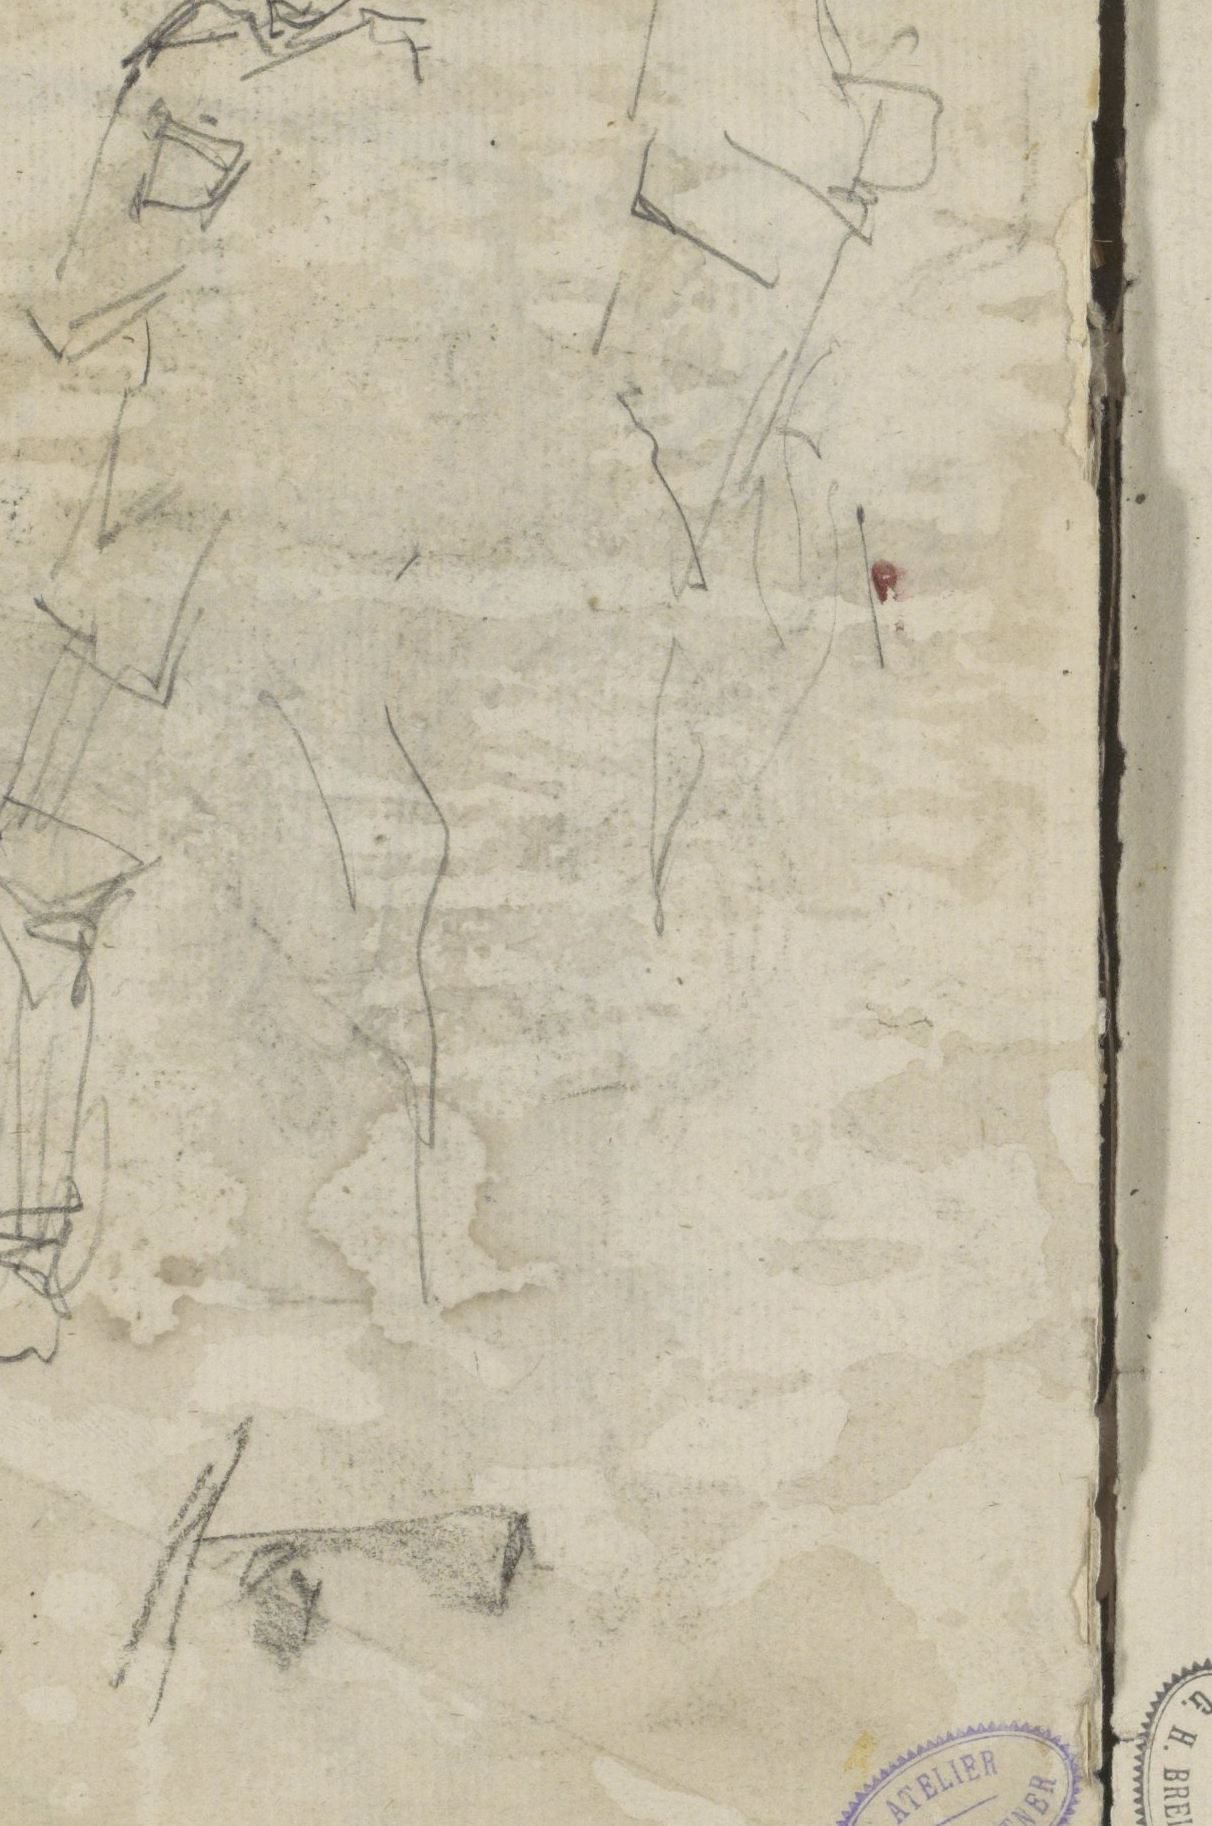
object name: sketchbook leaf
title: Twee staande mannen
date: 1880-1882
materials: chalk, paper, pencil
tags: standing figure, adult man, (military) uniforms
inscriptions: workshop stamp: Lugt 291d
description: Eén van hen draagt een uniform. Pagina F, los aangetroffen tussen blad 33 en het achterste schutblad in een schetsboek met 16 bladen.